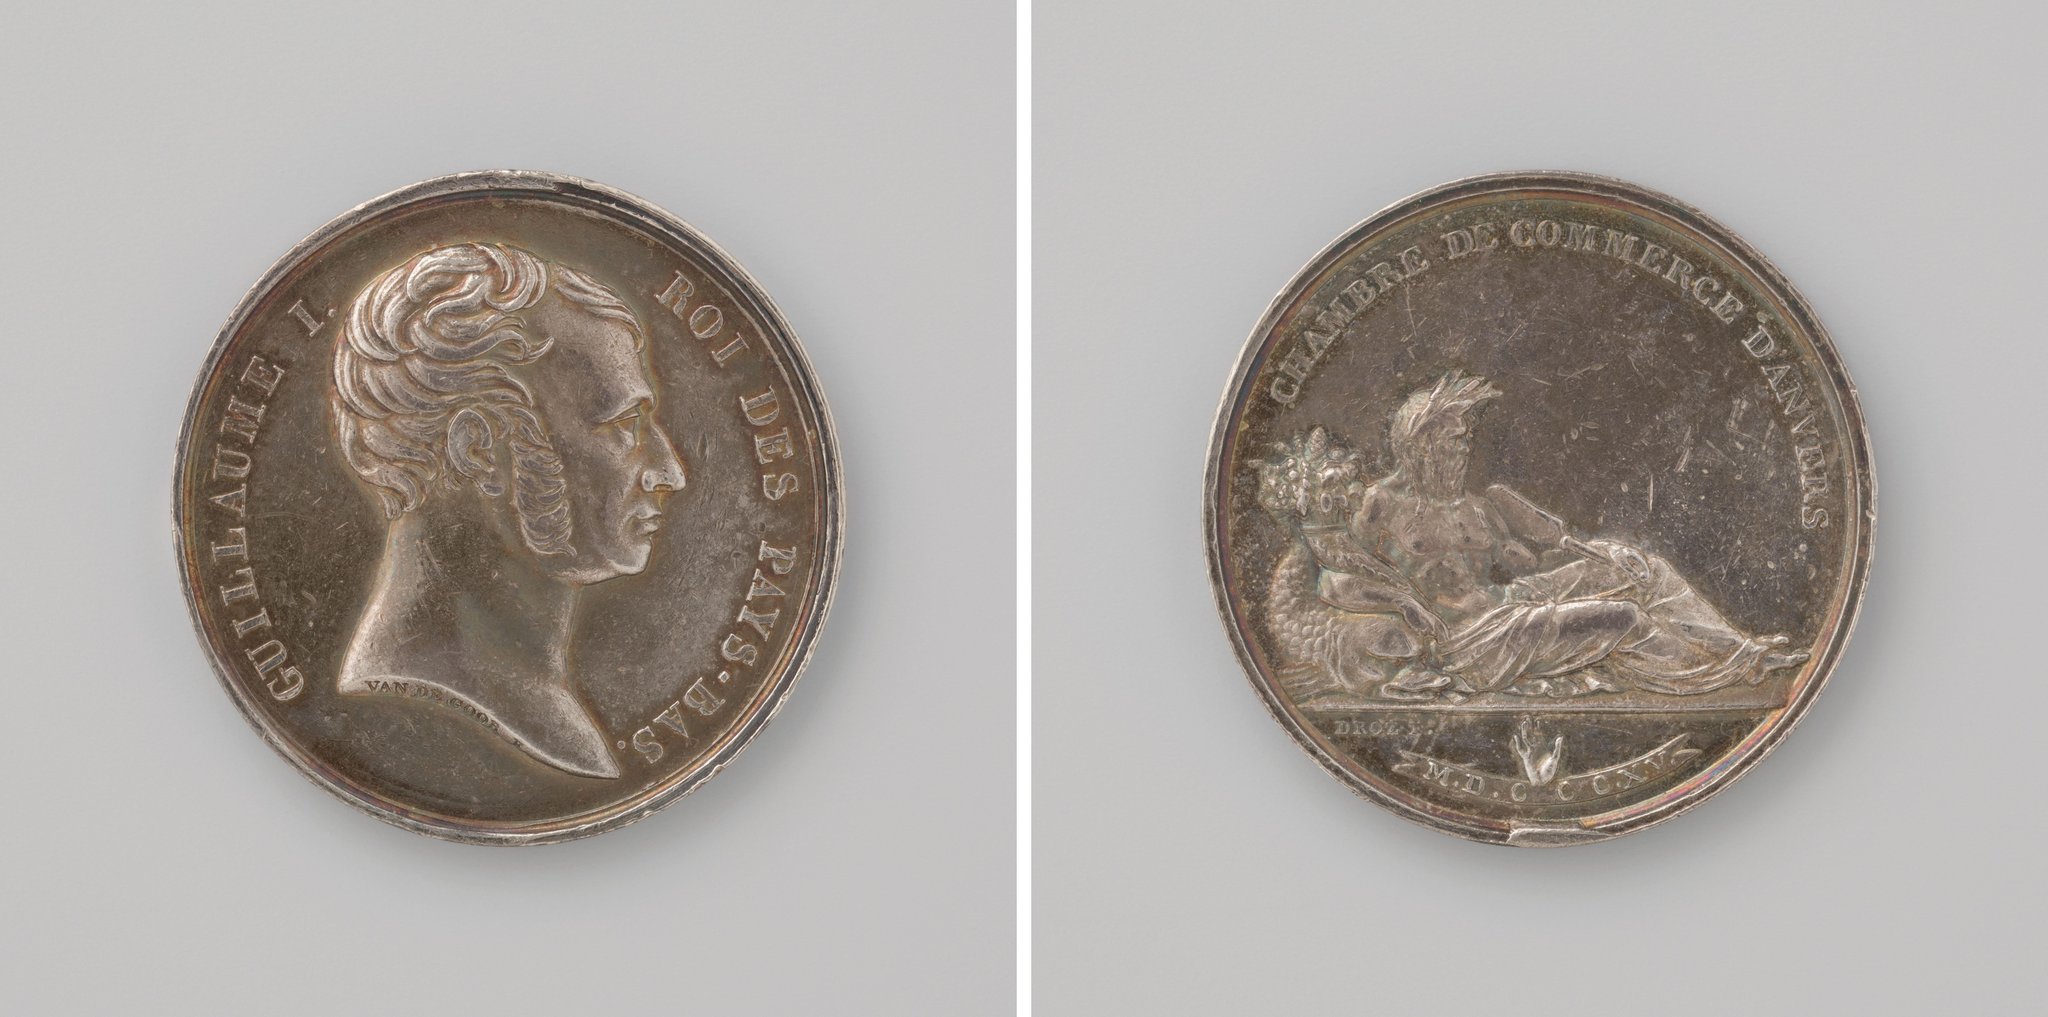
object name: history medal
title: Kamer van Koophandel te Antwerpen, ter ere van Willem I Frederik, koning der Nederlanden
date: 1815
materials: silver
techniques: striking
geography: brussels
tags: the hague, berlin, william i of the netherlands, antwerp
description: Zilveren penning. Voorzijde: borststuk man binnen omschrift. Keerzijde: riviergod met roer en gevulde hoorn van overvloed, leunend op dolfijn binnen omschrift; afsnede: jaartal op wimpel, signatuur en geopende, omhoog gestoken hand